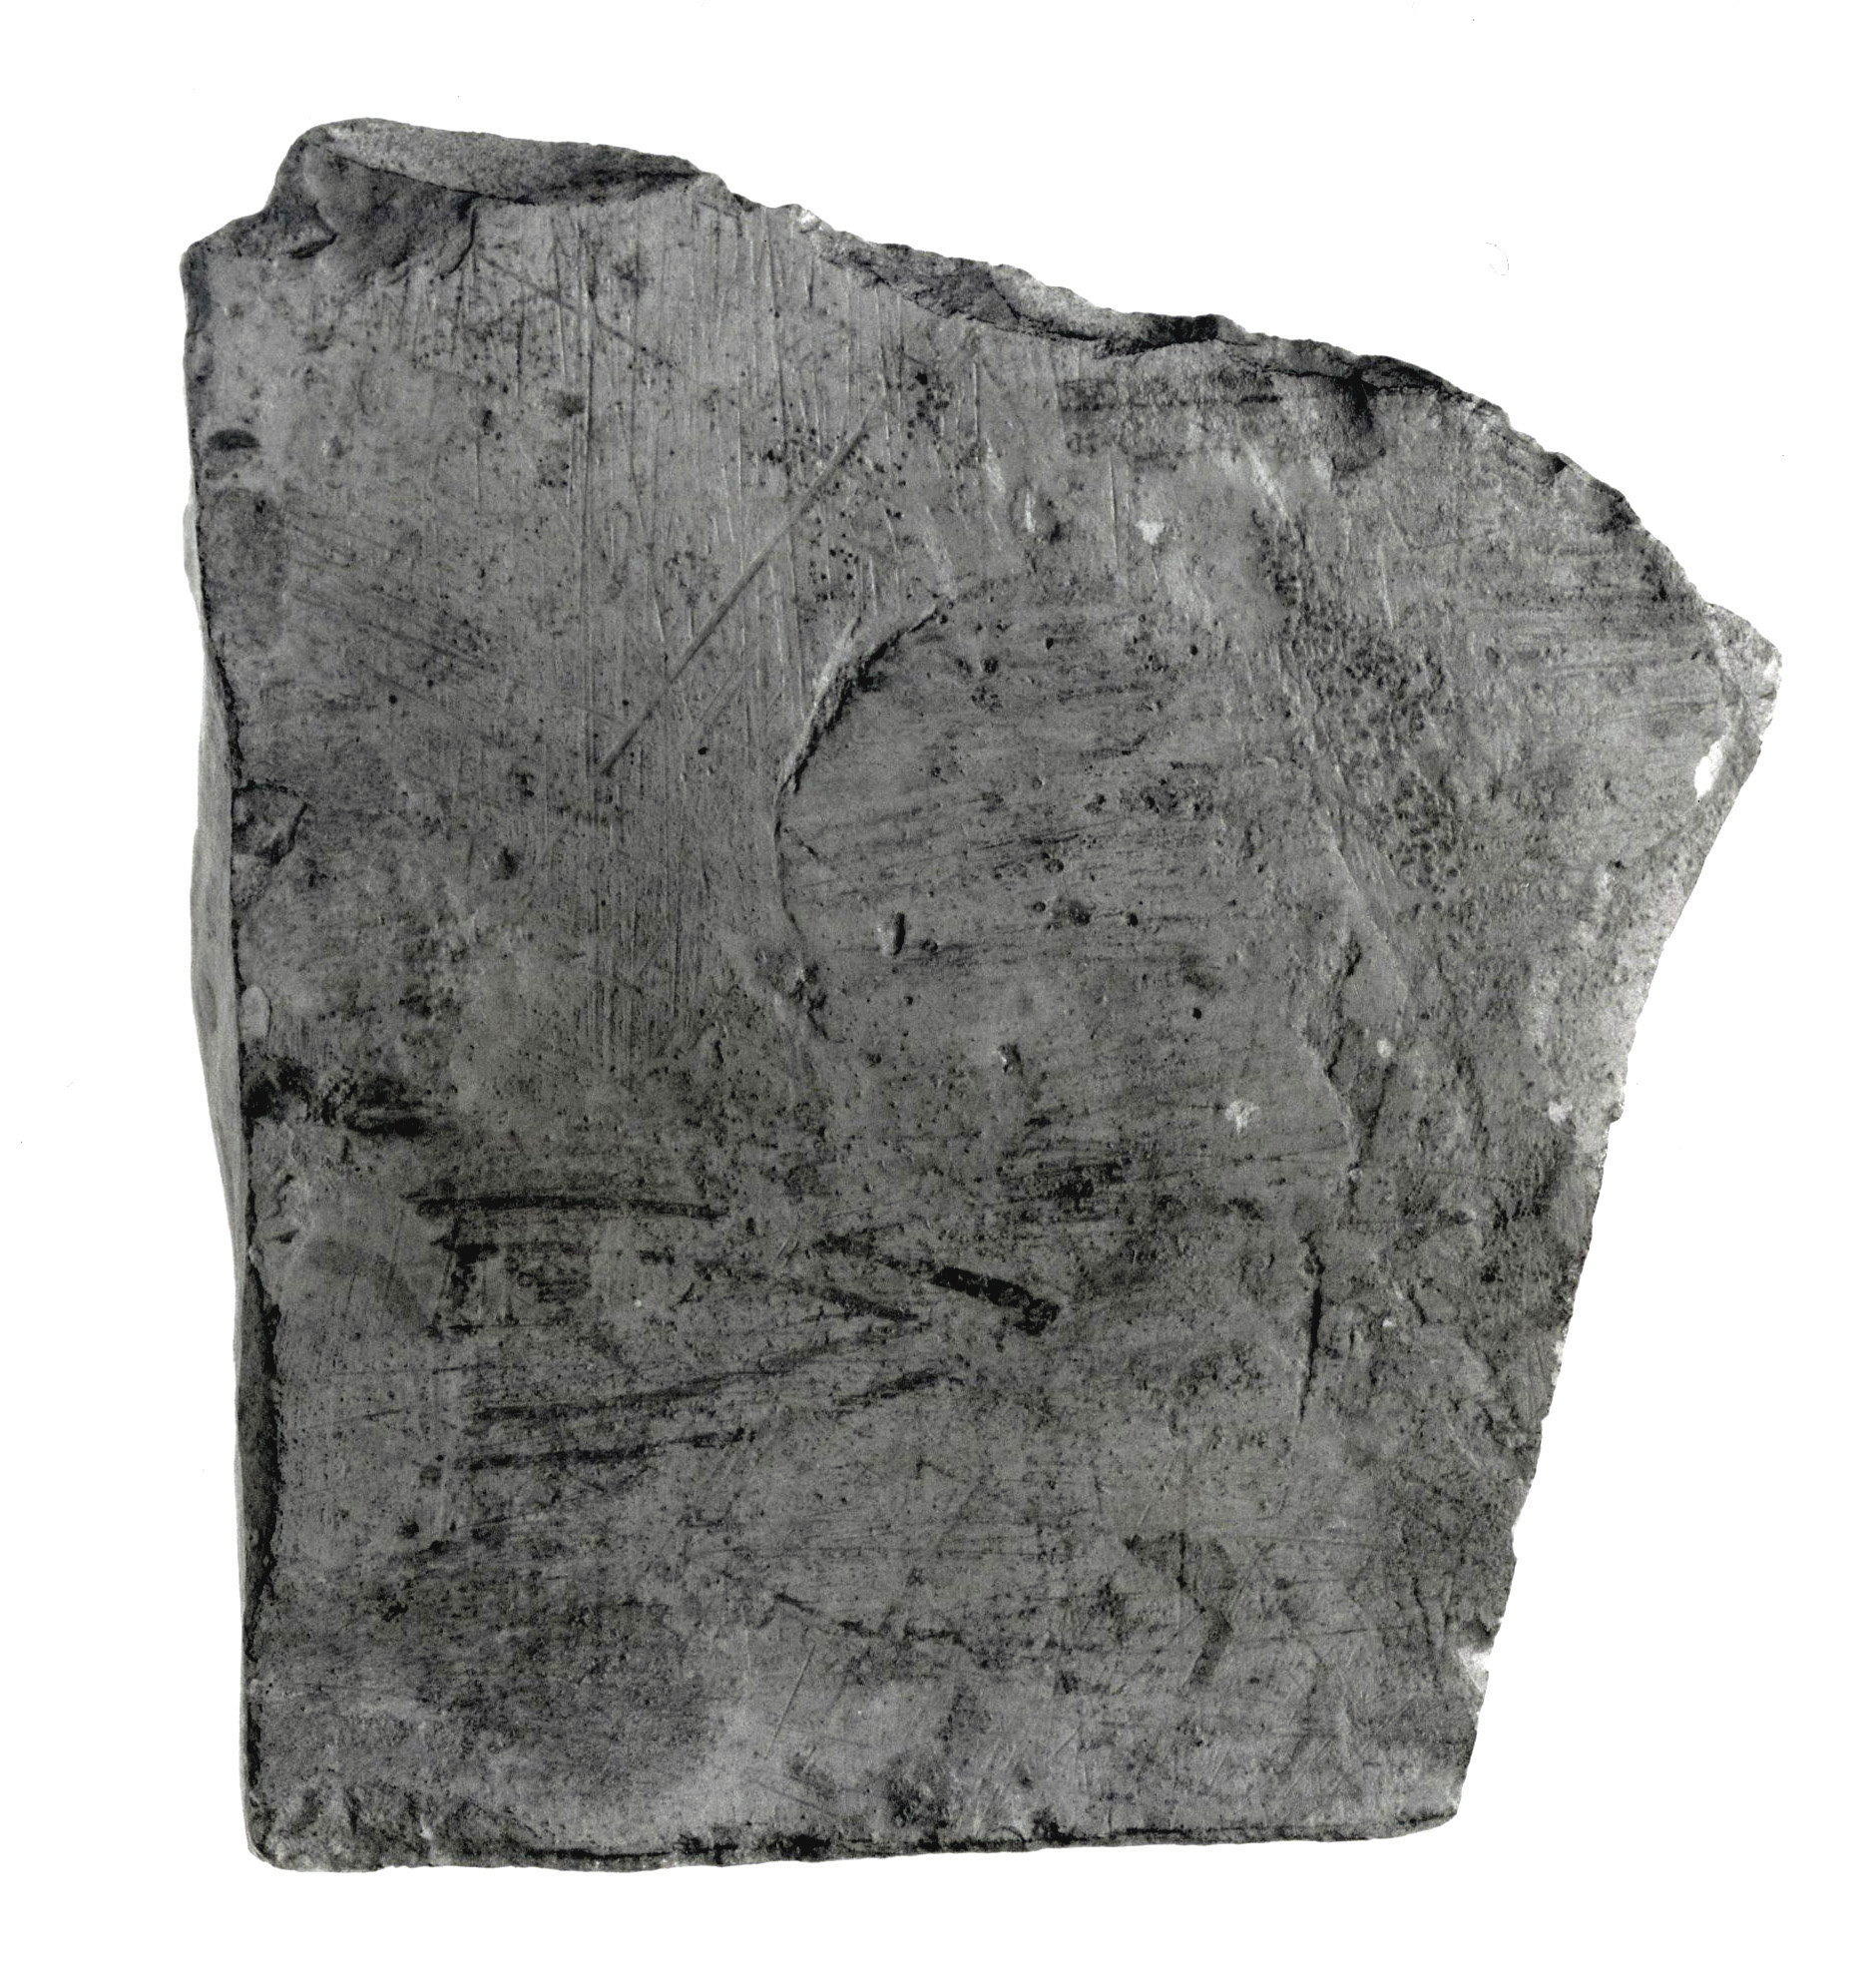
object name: relief, tomb of nespekashuty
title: Drawing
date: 664-610 BCE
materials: limestone, varnish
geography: egypt